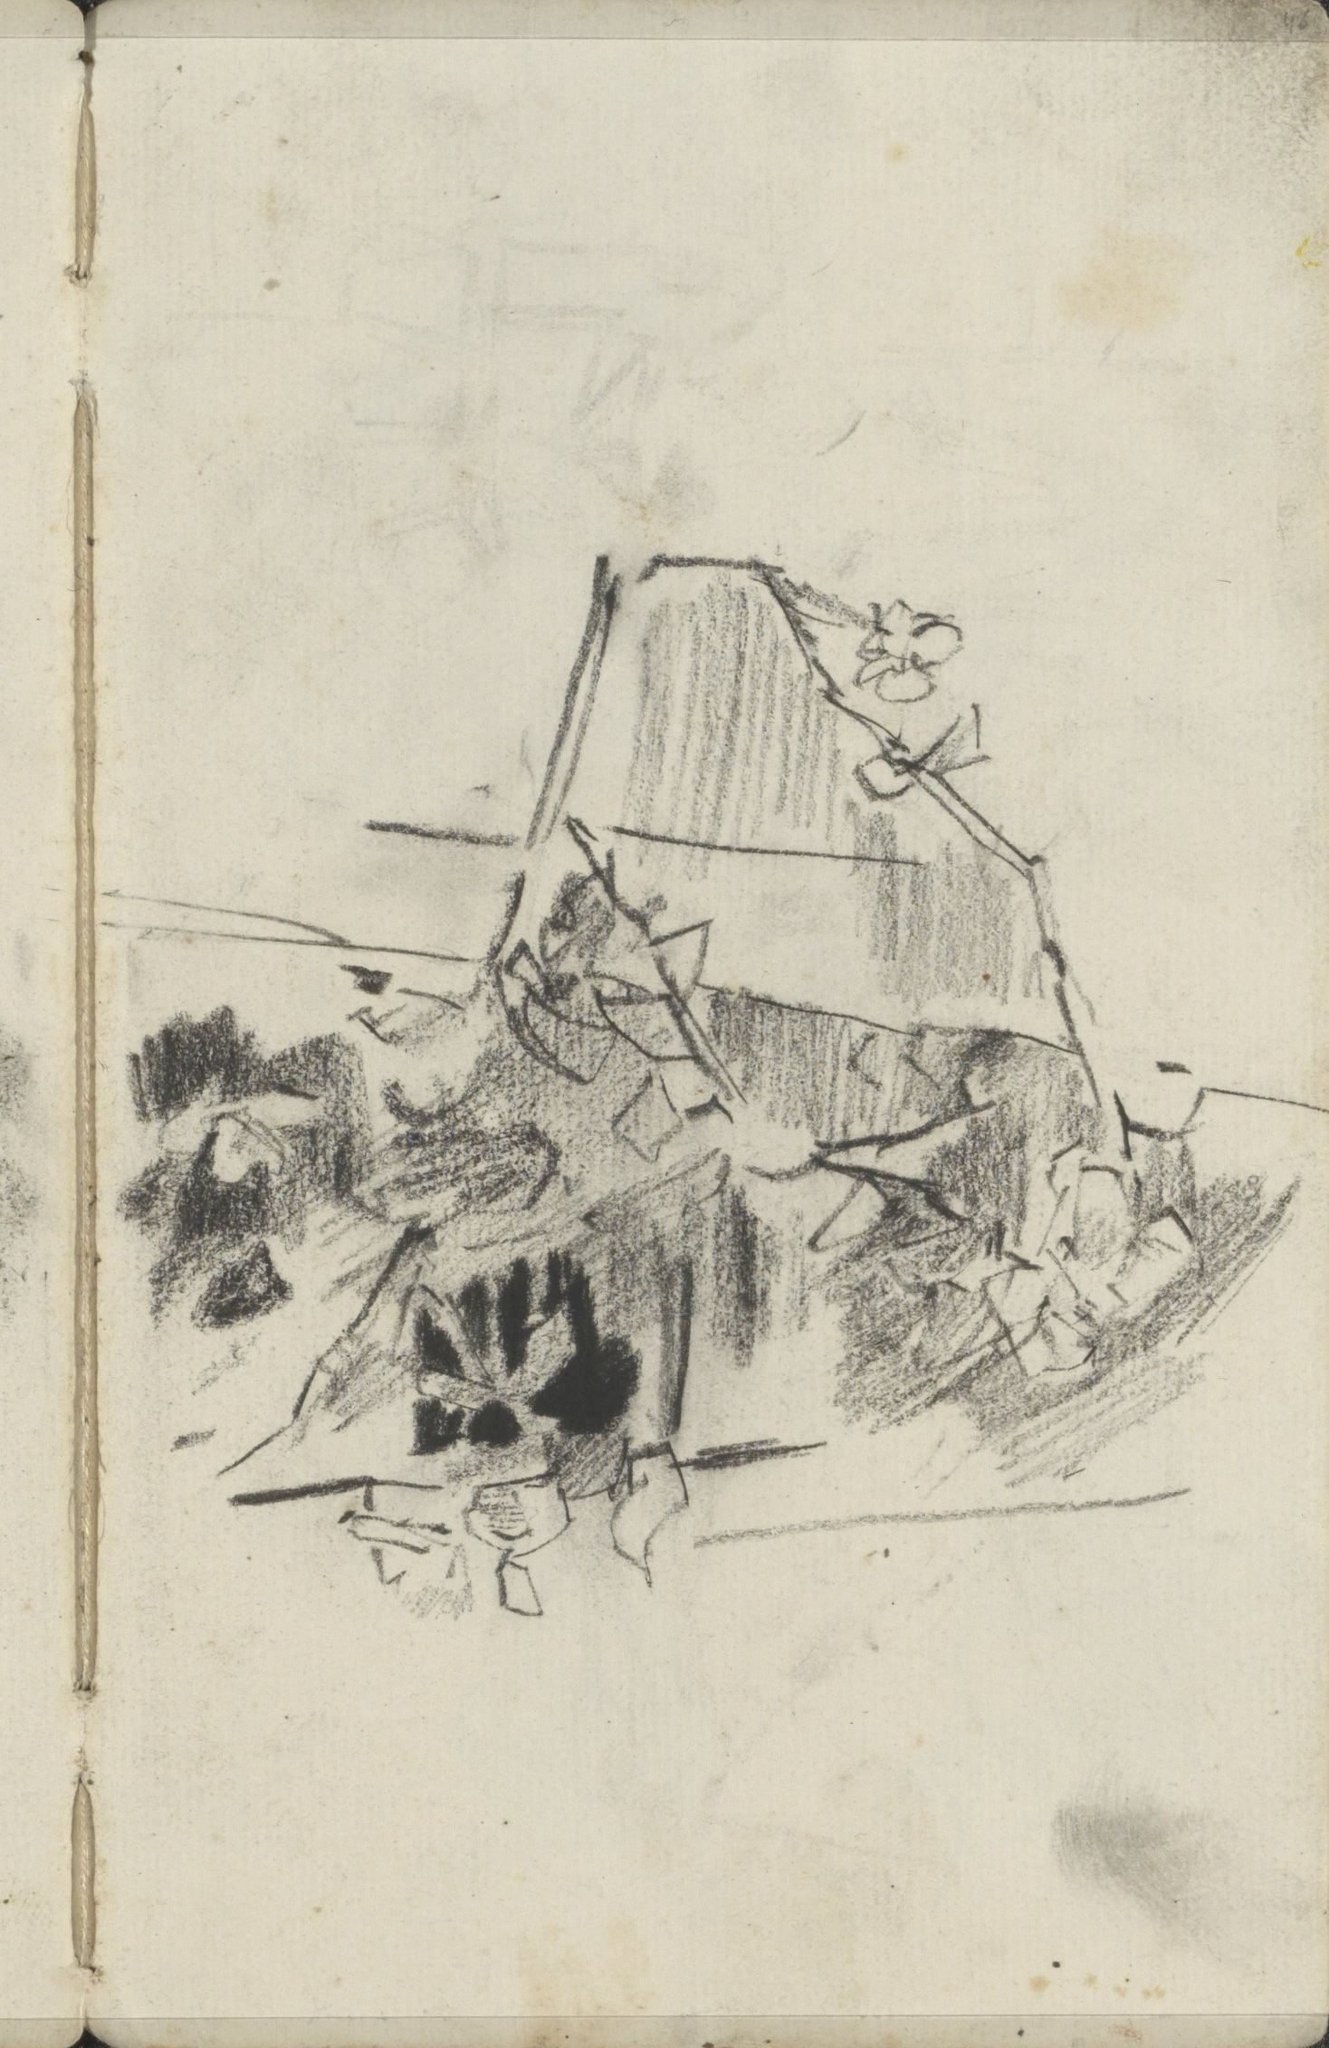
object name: sketchbook leaf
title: Studie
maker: george hendrik breitner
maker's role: draughtsman, painter, print maker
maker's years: 1857-1923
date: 1884-1886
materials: chalk, paper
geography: paris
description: Pagina 46 uit een schetsboek met 25 bladen.